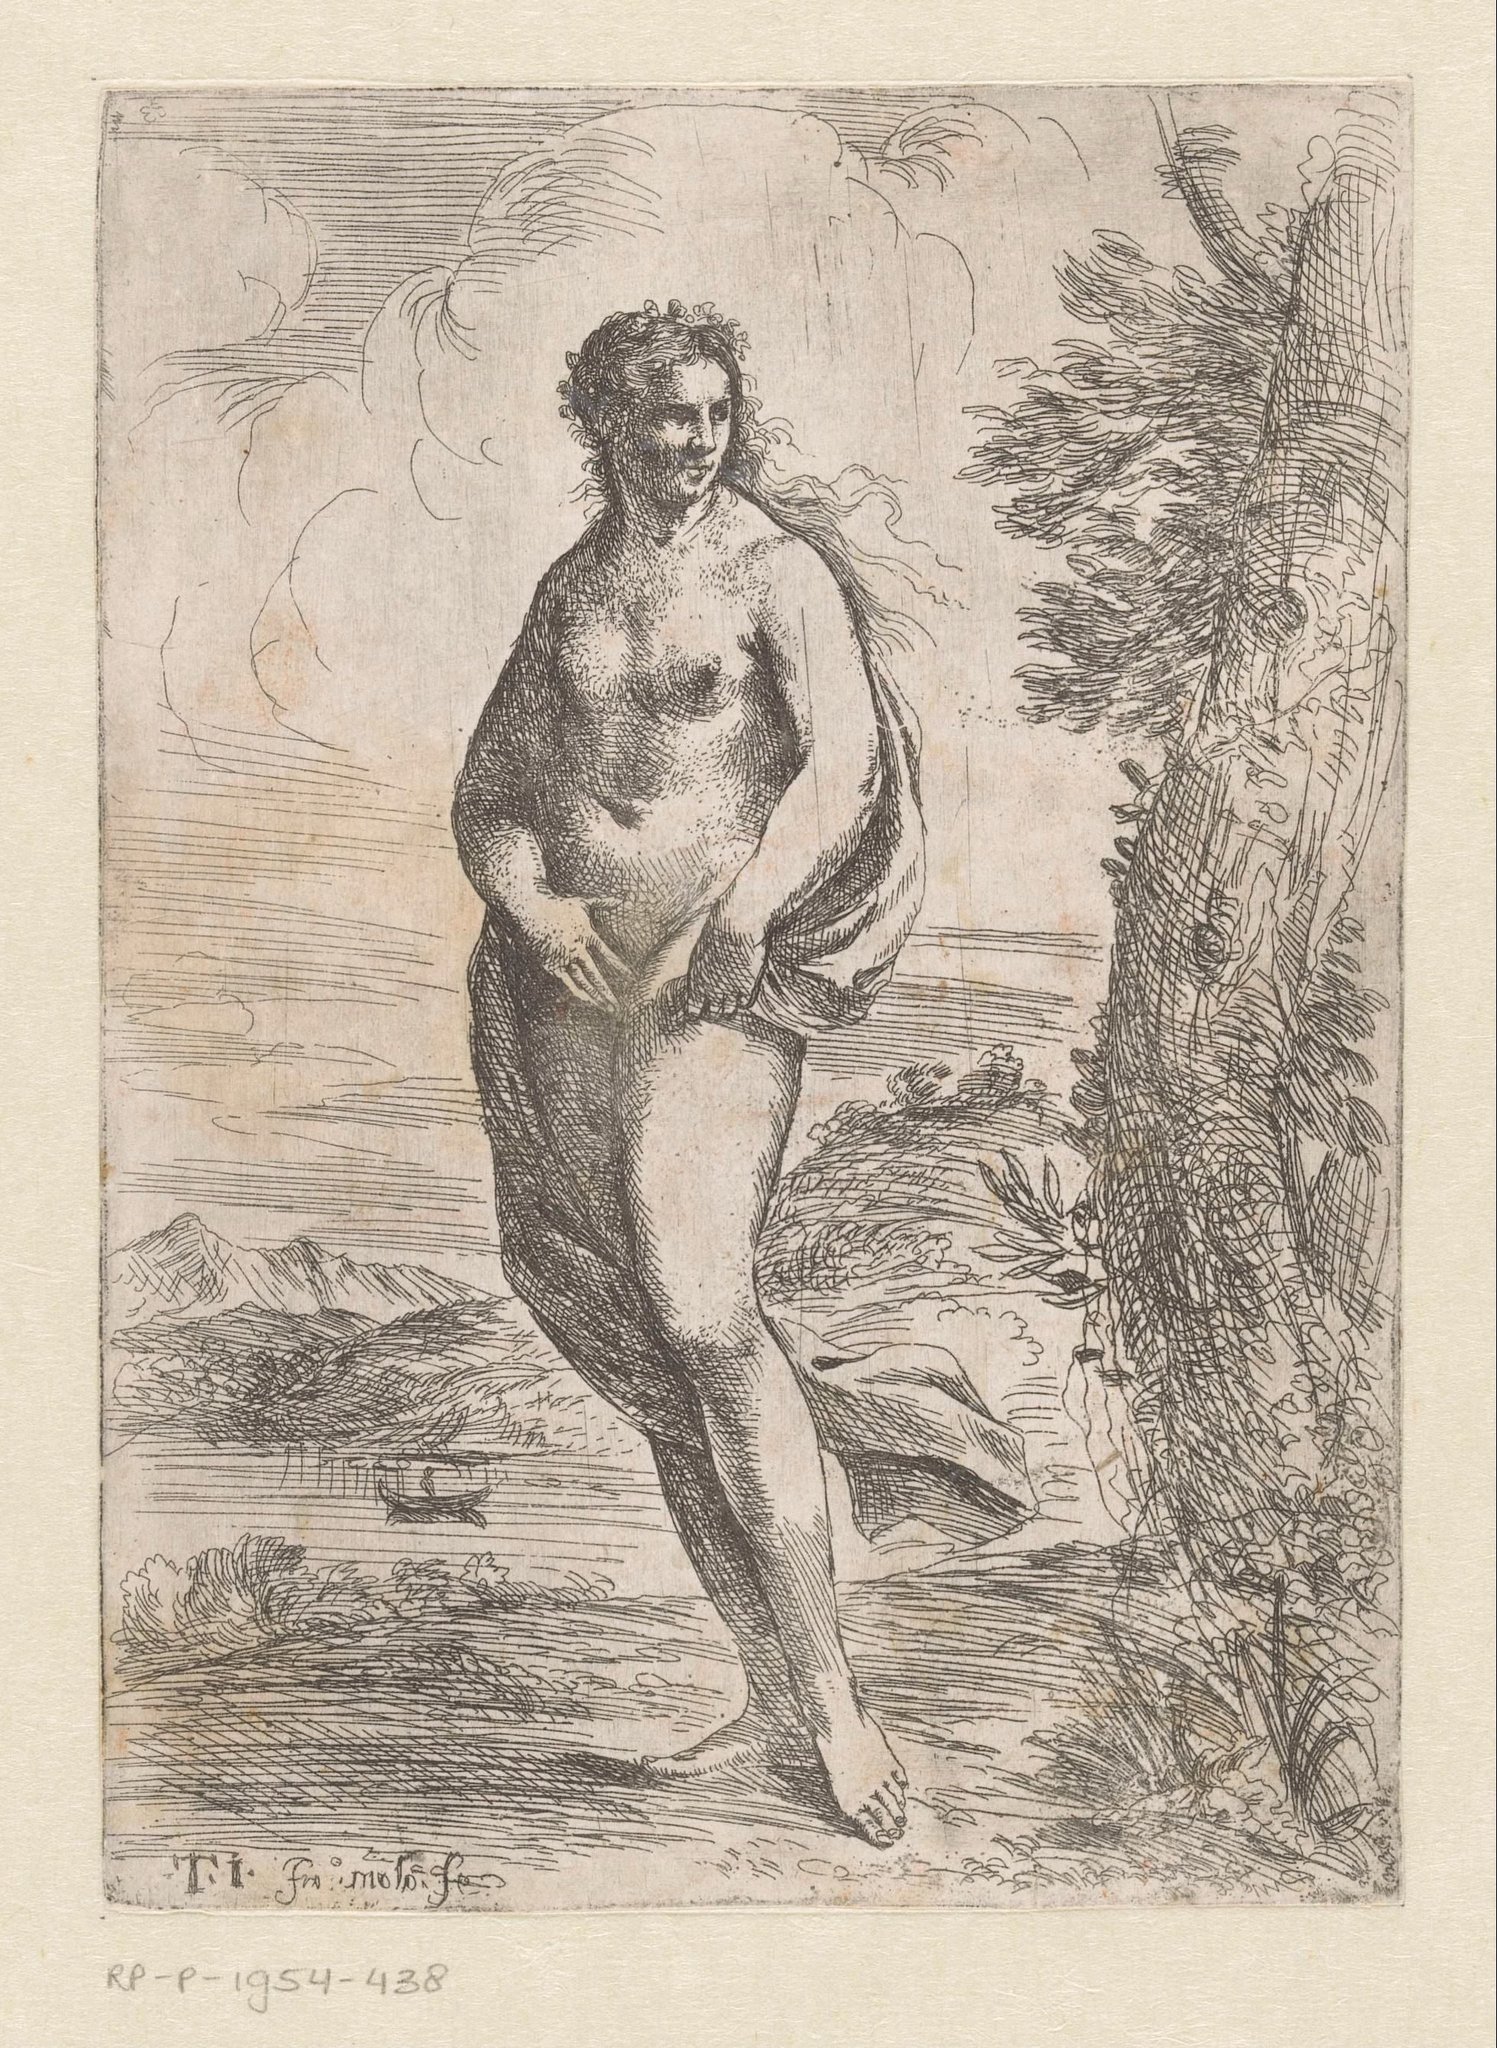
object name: print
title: Staande naakte vrouw in landschap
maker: pier francesco mola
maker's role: draughtsman, print maker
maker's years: 1612-1666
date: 1622-1666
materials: paper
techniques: etching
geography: italy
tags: landscapes, nude with covered genitals - aa - female human figure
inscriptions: collector's mark: Lugt 2228, collector's mark: Lugt 2760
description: Lichte beschadiging door wrijving bij de schaamstreek van de vrouw.